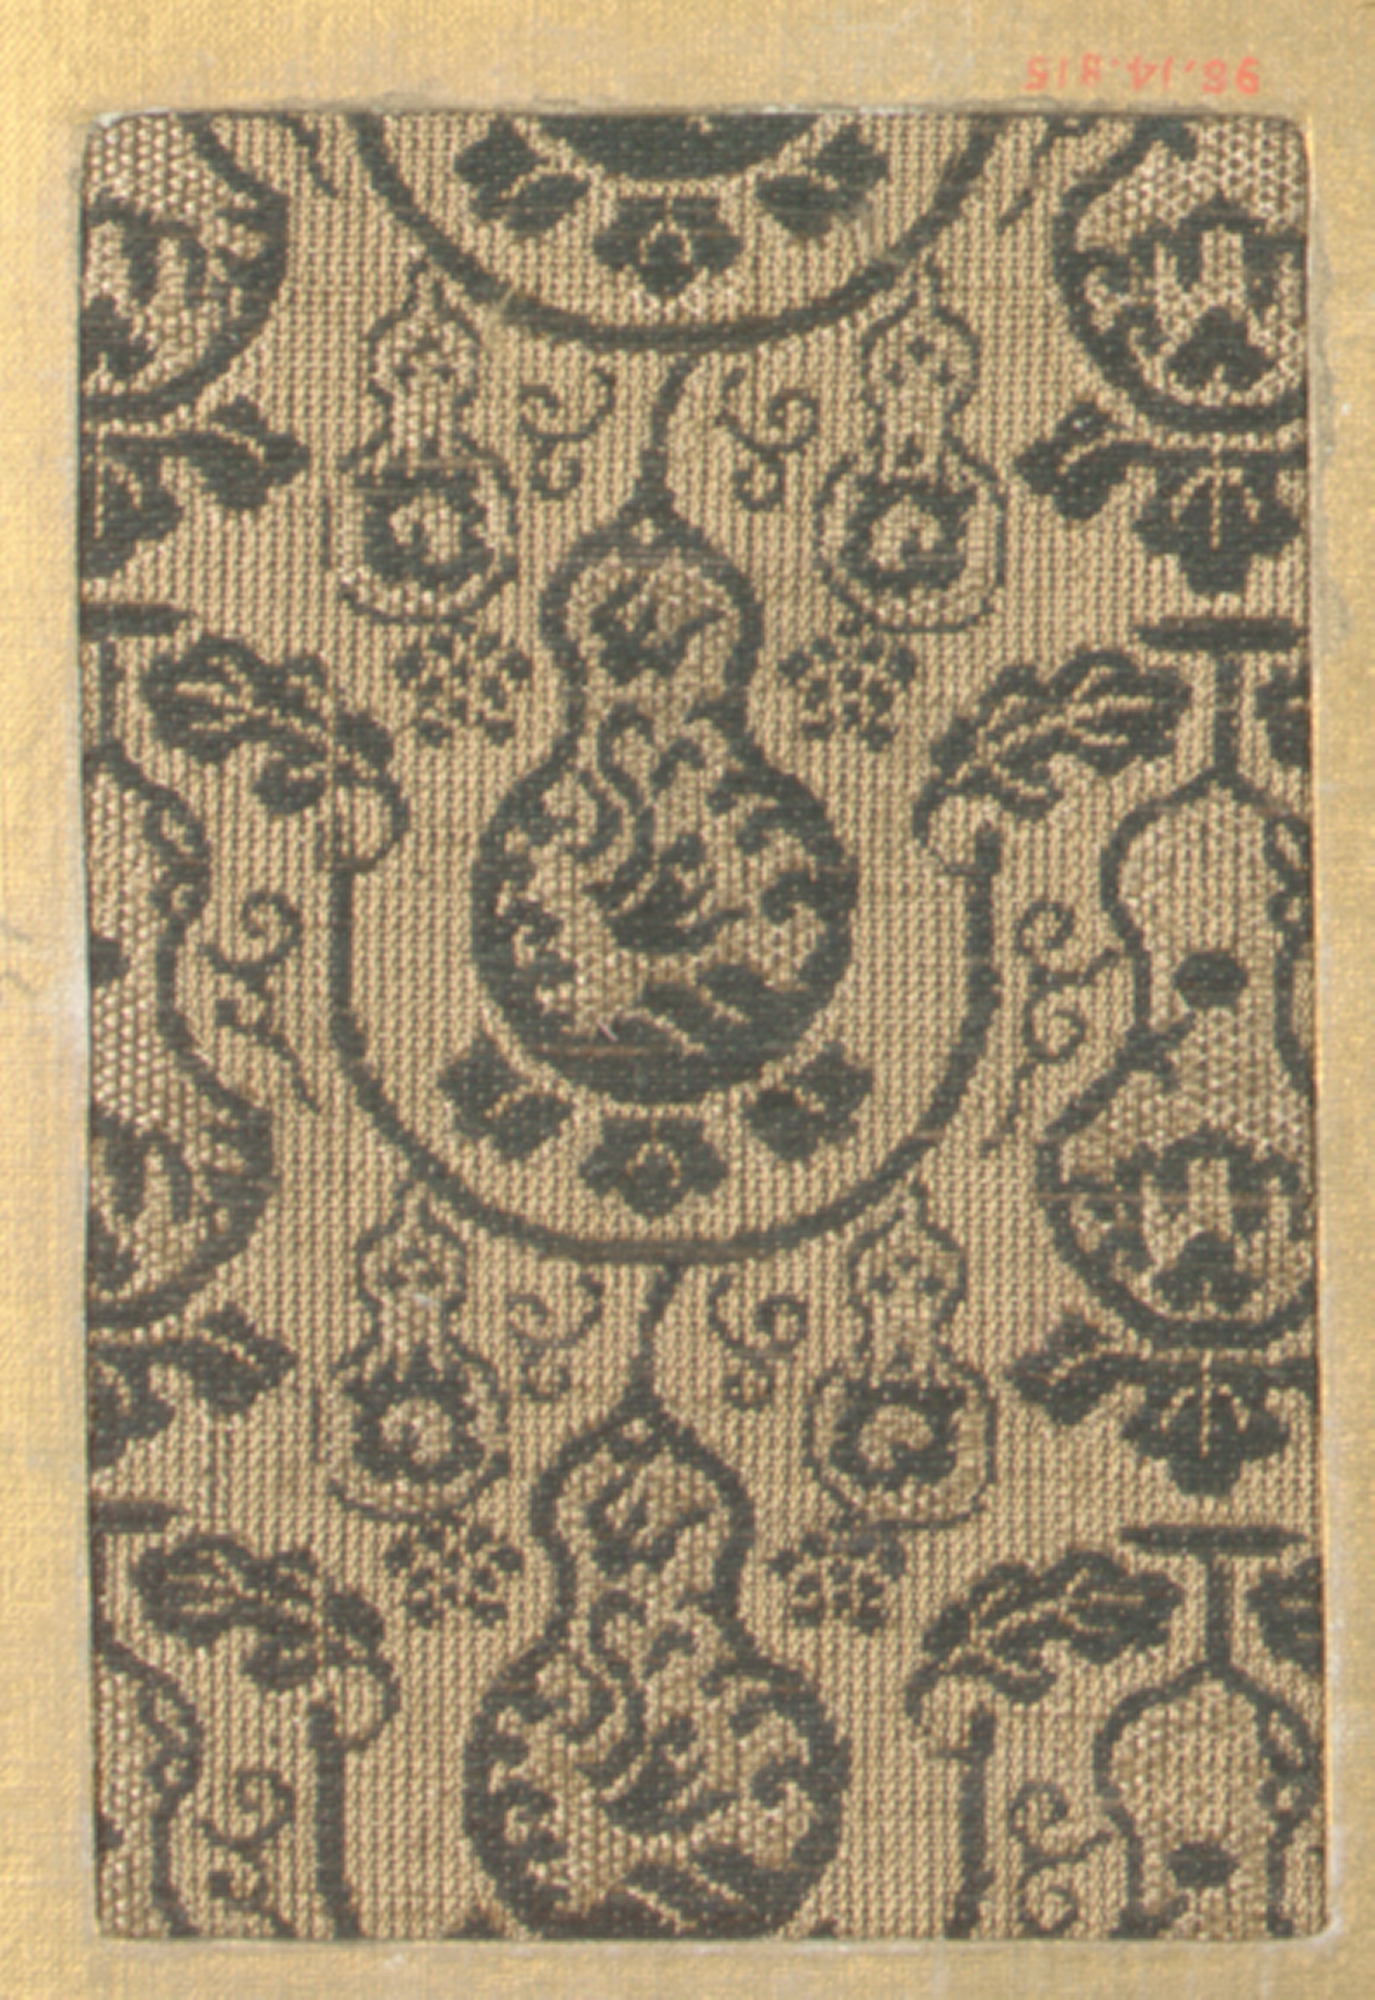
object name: piece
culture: japanese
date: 1701-1900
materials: silk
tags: gourds